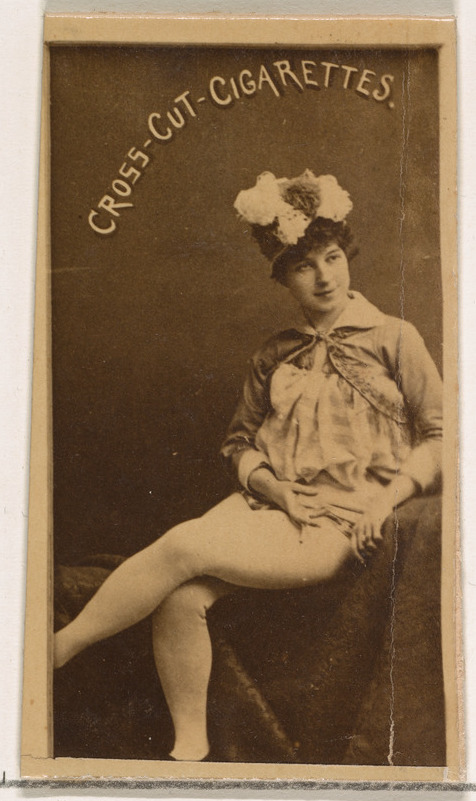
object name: print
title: Seated actress wearing tights and feathered hat, from the Actors and Actresses series (N145-1) issued by Duke Sons & Co. to promote Cross Cut Cigarettes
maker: w. duke, sons & co.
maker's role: publisher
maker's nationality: american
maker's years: 1870-1920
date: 1880-1889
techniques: albumen silver print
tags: portraits,women,actresses